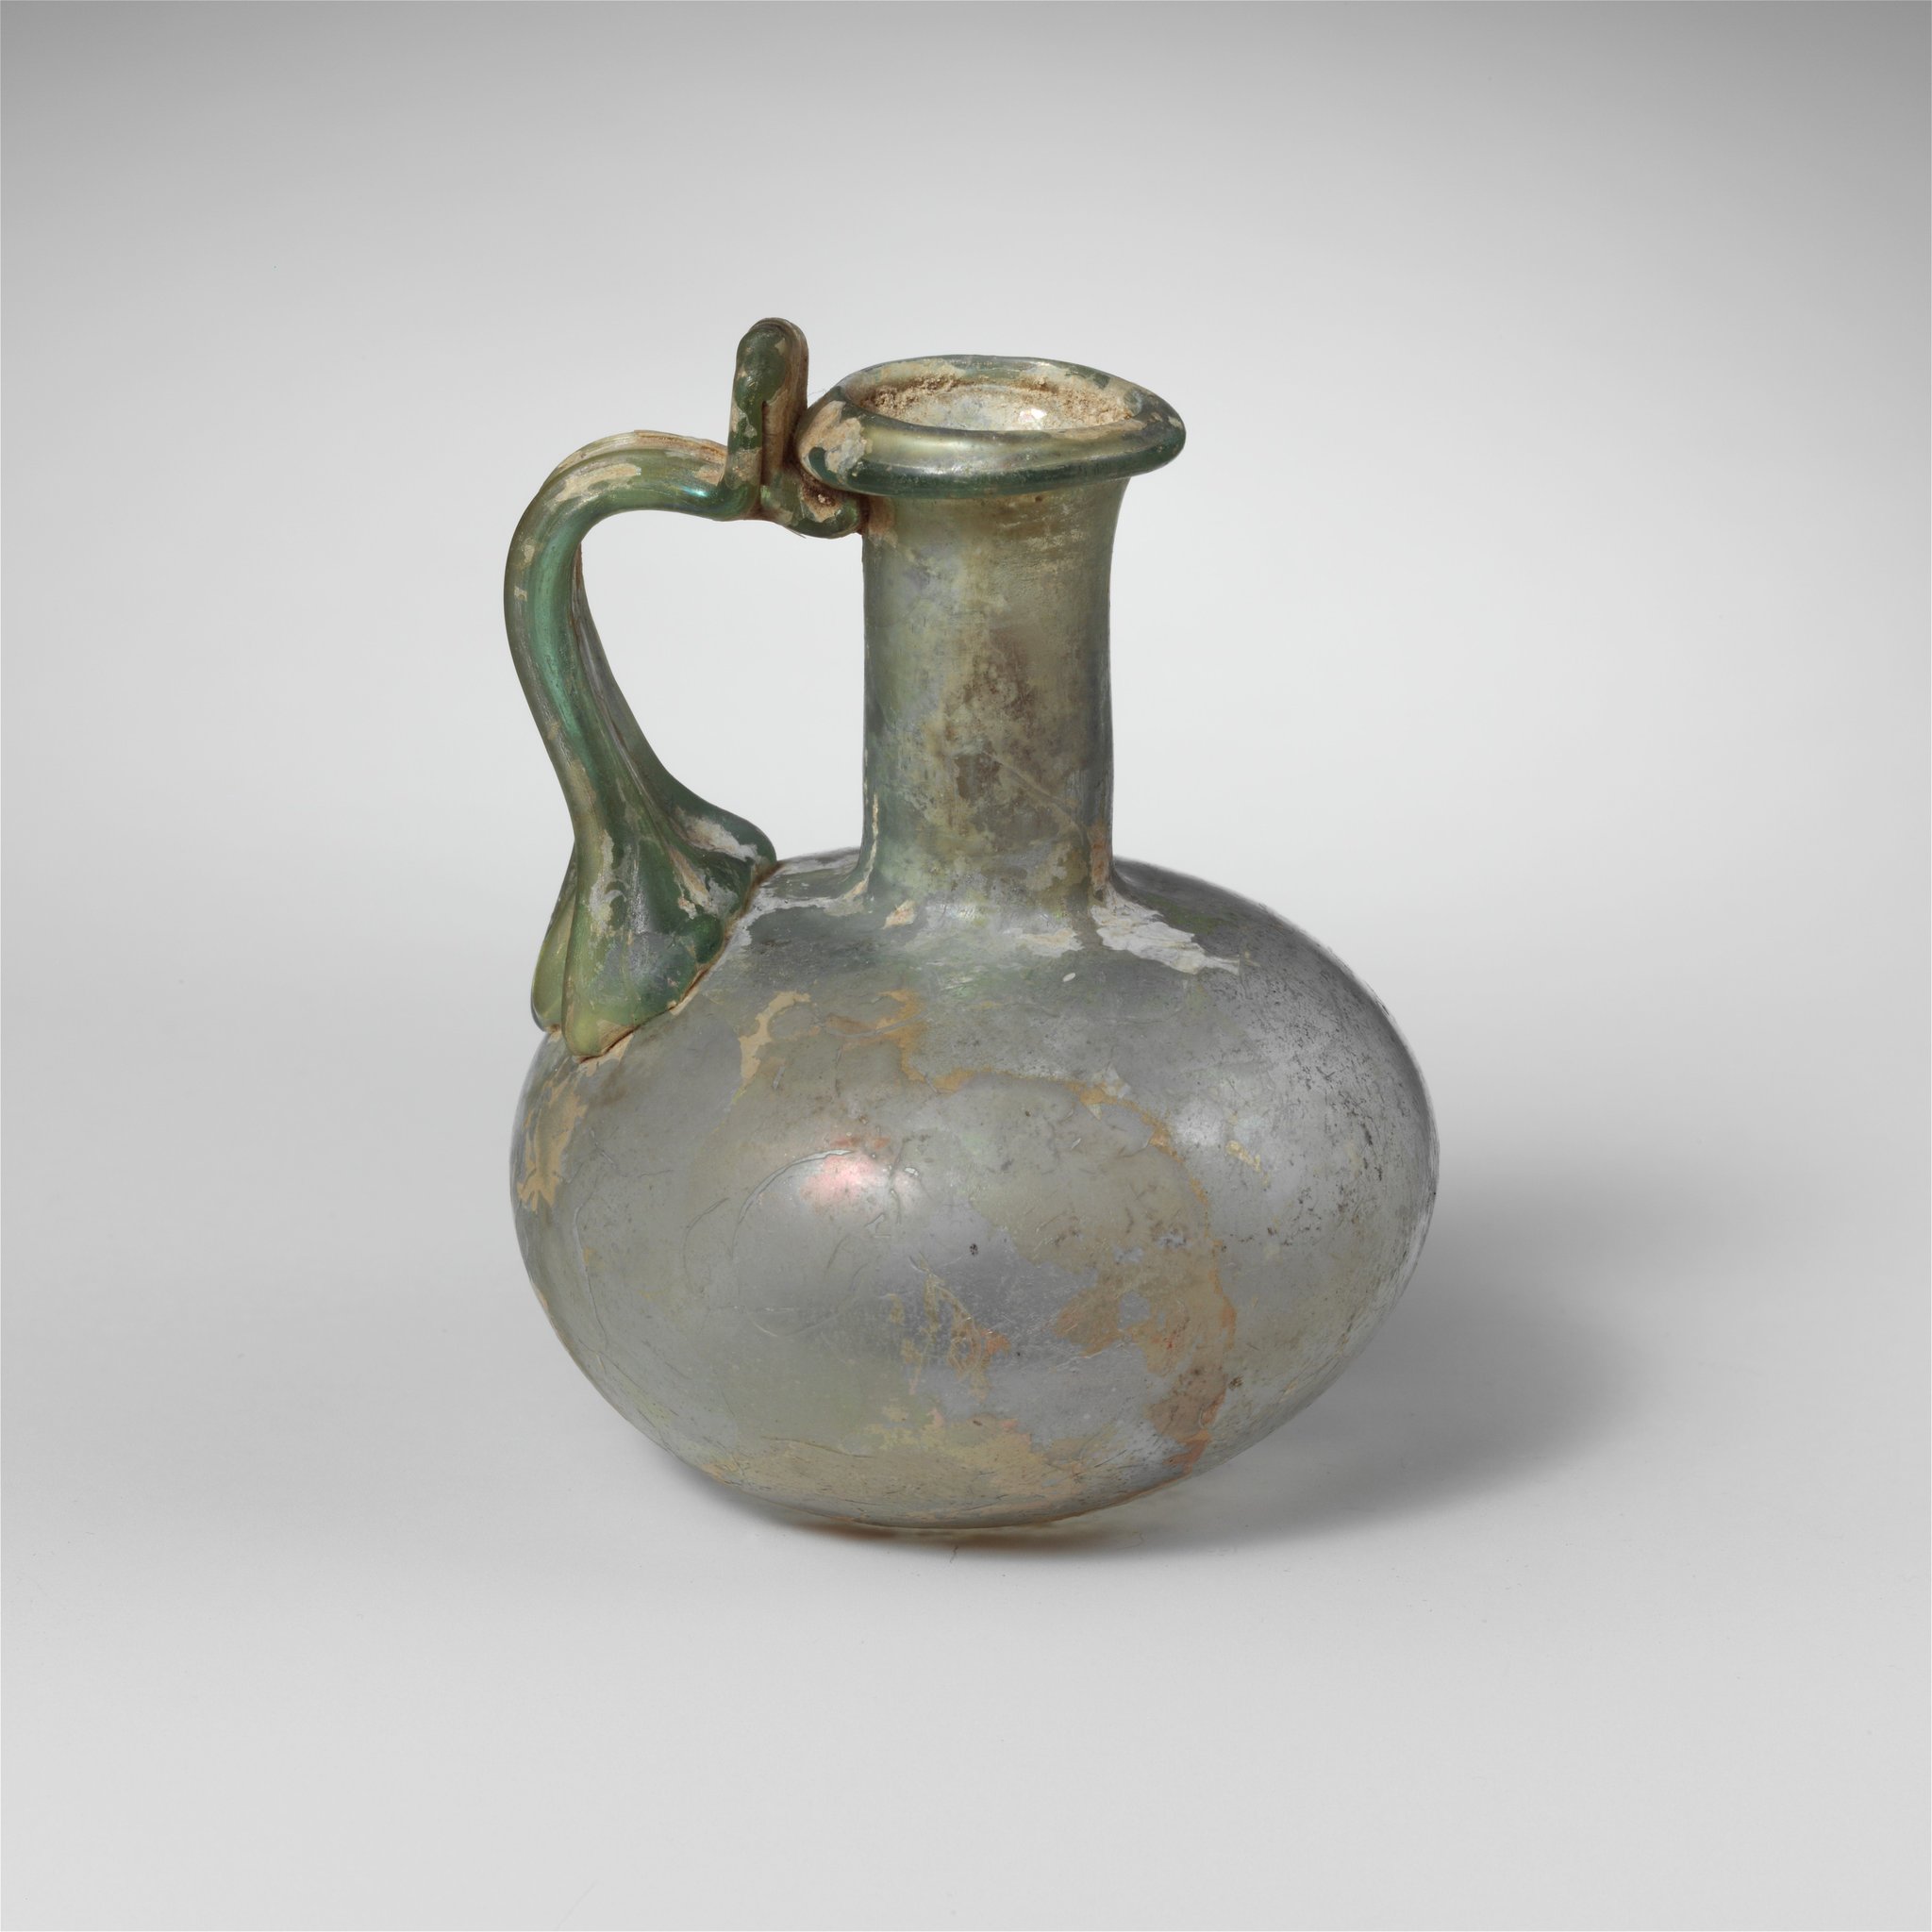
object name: jug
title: Glass jug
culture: roman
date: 1-200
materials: glass